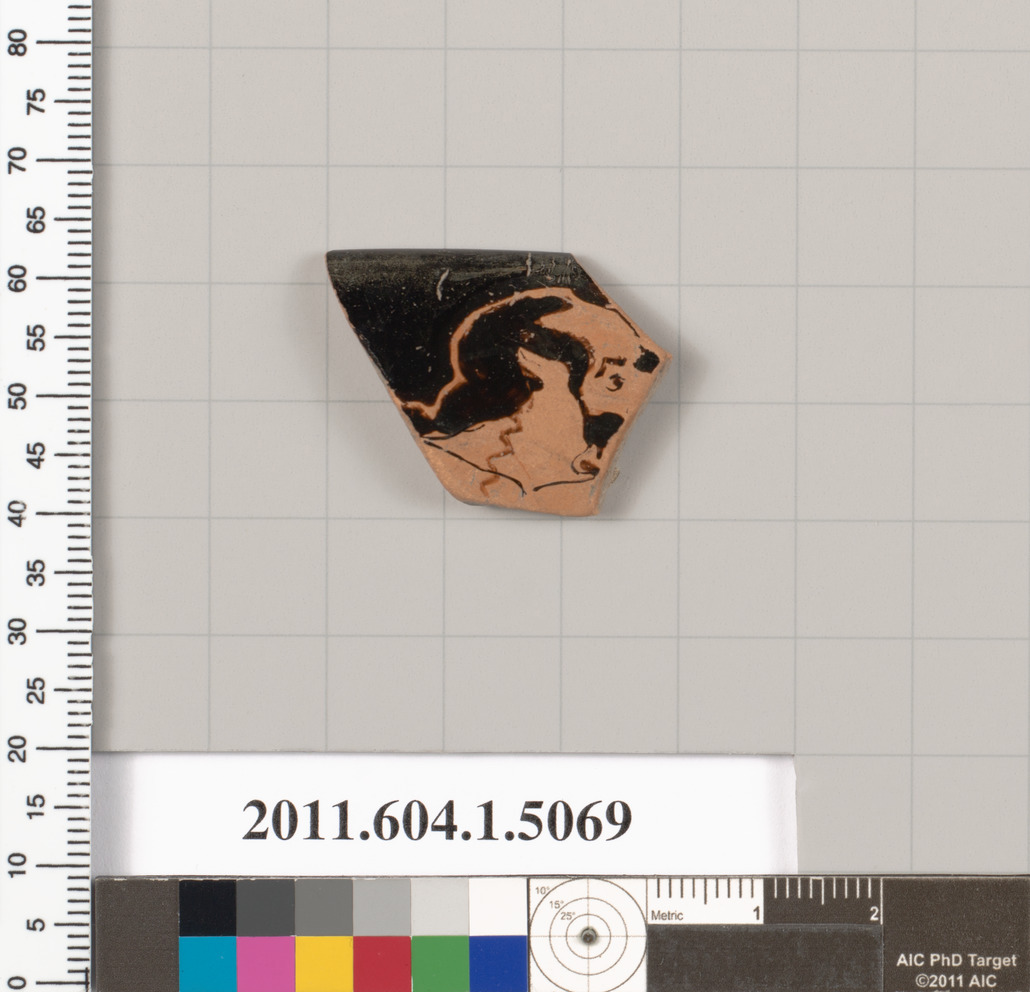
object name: kylix fragment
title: Terracotta rim fragment of a kylix (drinking cup)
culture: greek, attic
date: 475-451 BCE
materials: terracotta